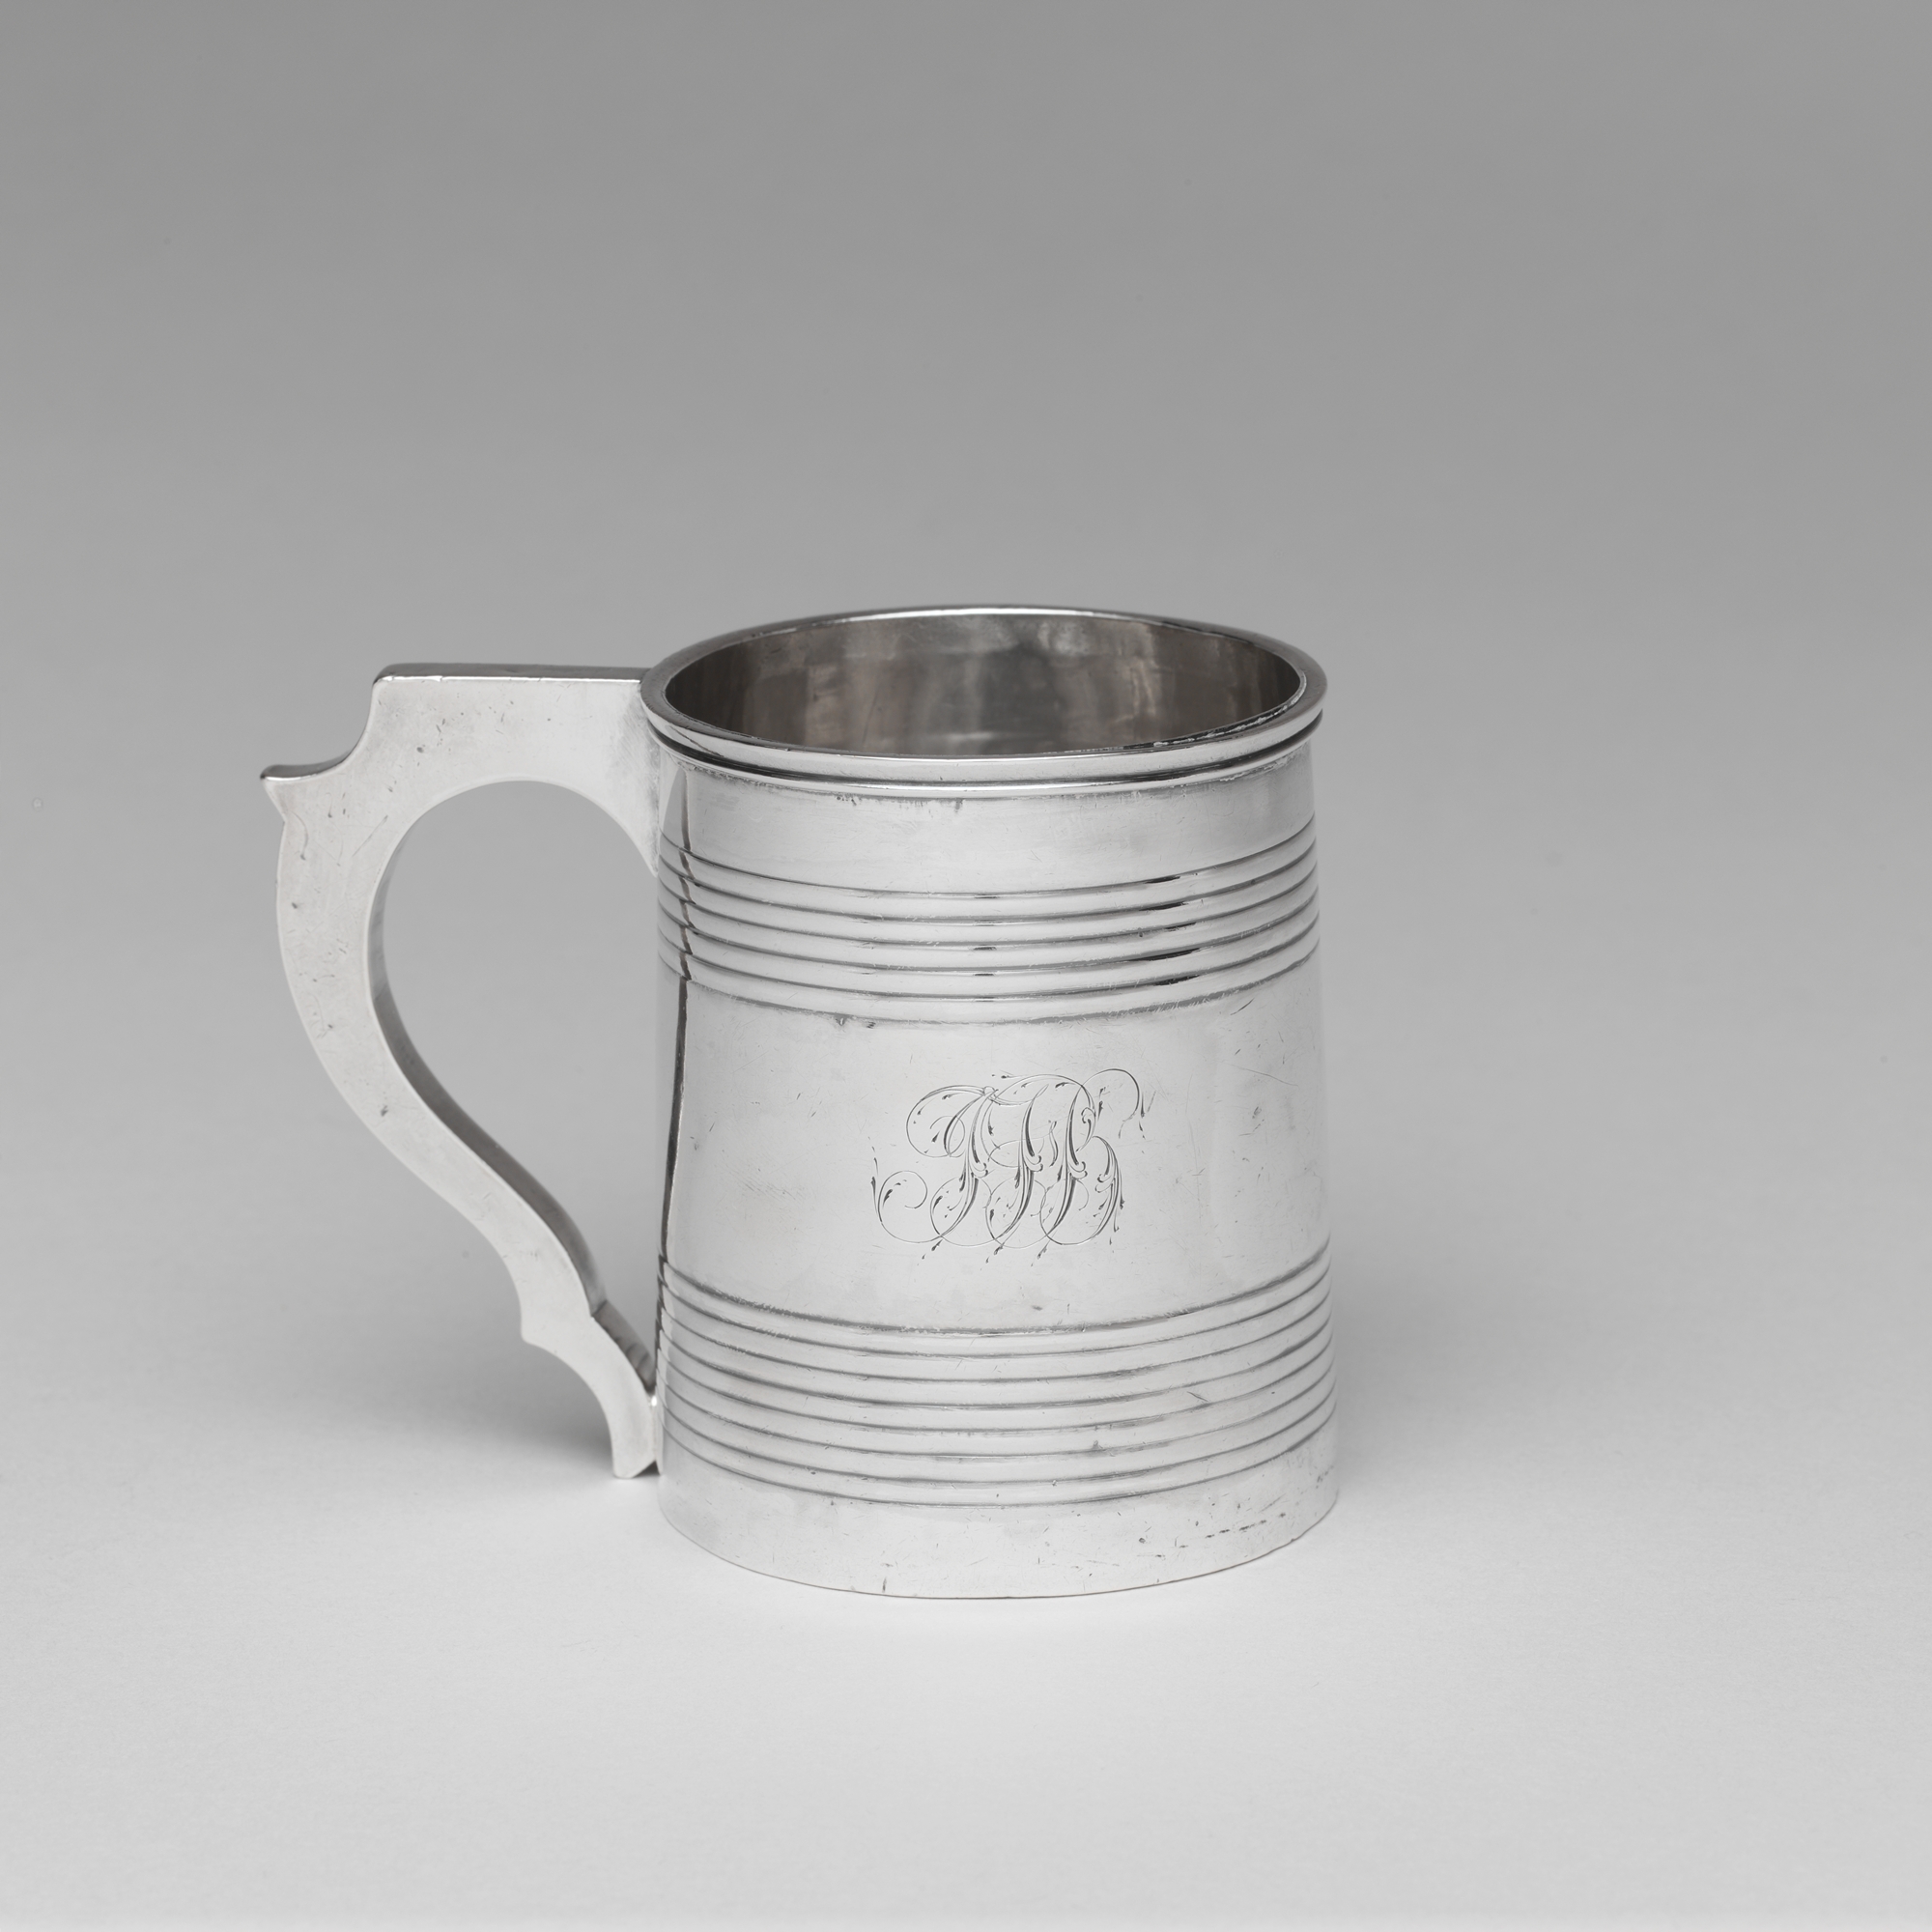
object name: mug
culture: american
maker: john w. forbes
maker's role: maker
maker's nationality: american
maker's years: 1781-1864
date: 1820-1830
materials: silver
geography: united states